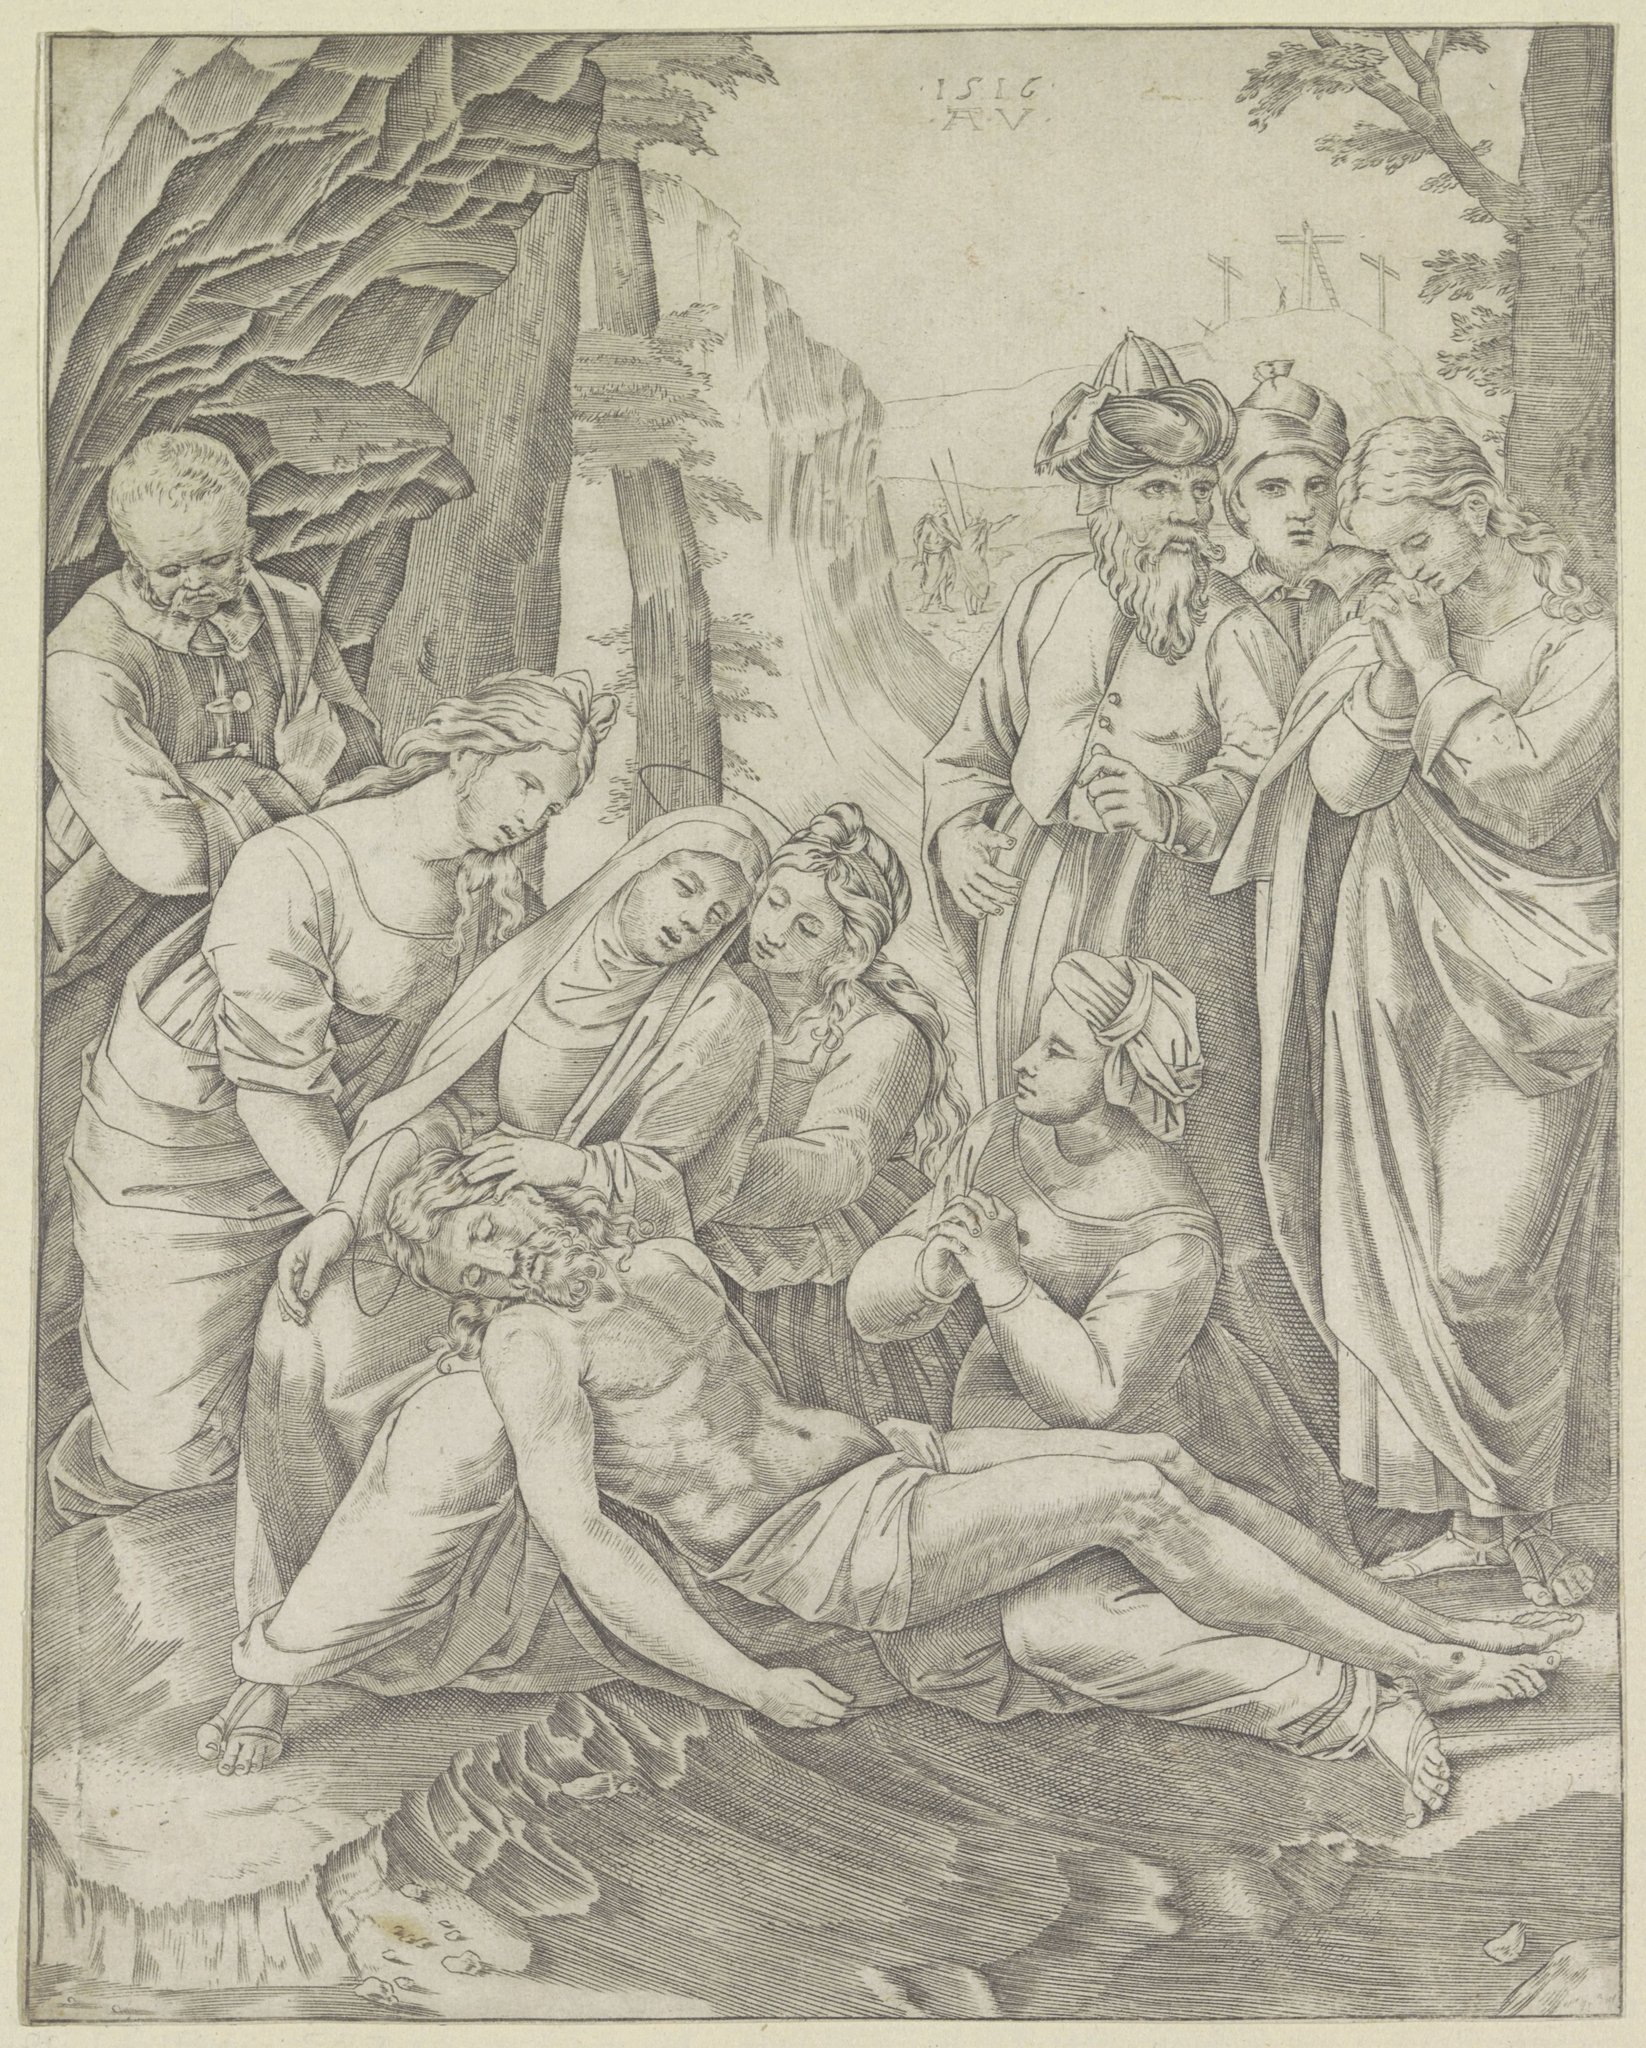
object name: print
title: Bewening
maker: agostino veneziano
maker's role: draughtsman, painter, print maker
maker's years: 1490-1536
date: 1516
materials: paper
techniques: engraving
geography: italy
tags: lamentation over the dead christ by his relatives and friends (christ usually without crown of thorns)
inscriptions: collector's mark: Lugt 12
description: Het lichaam van Christus wordt beweend door de Maria's en andere volgelingen. Op de achtergrond Golgotha met de drie kruisen.